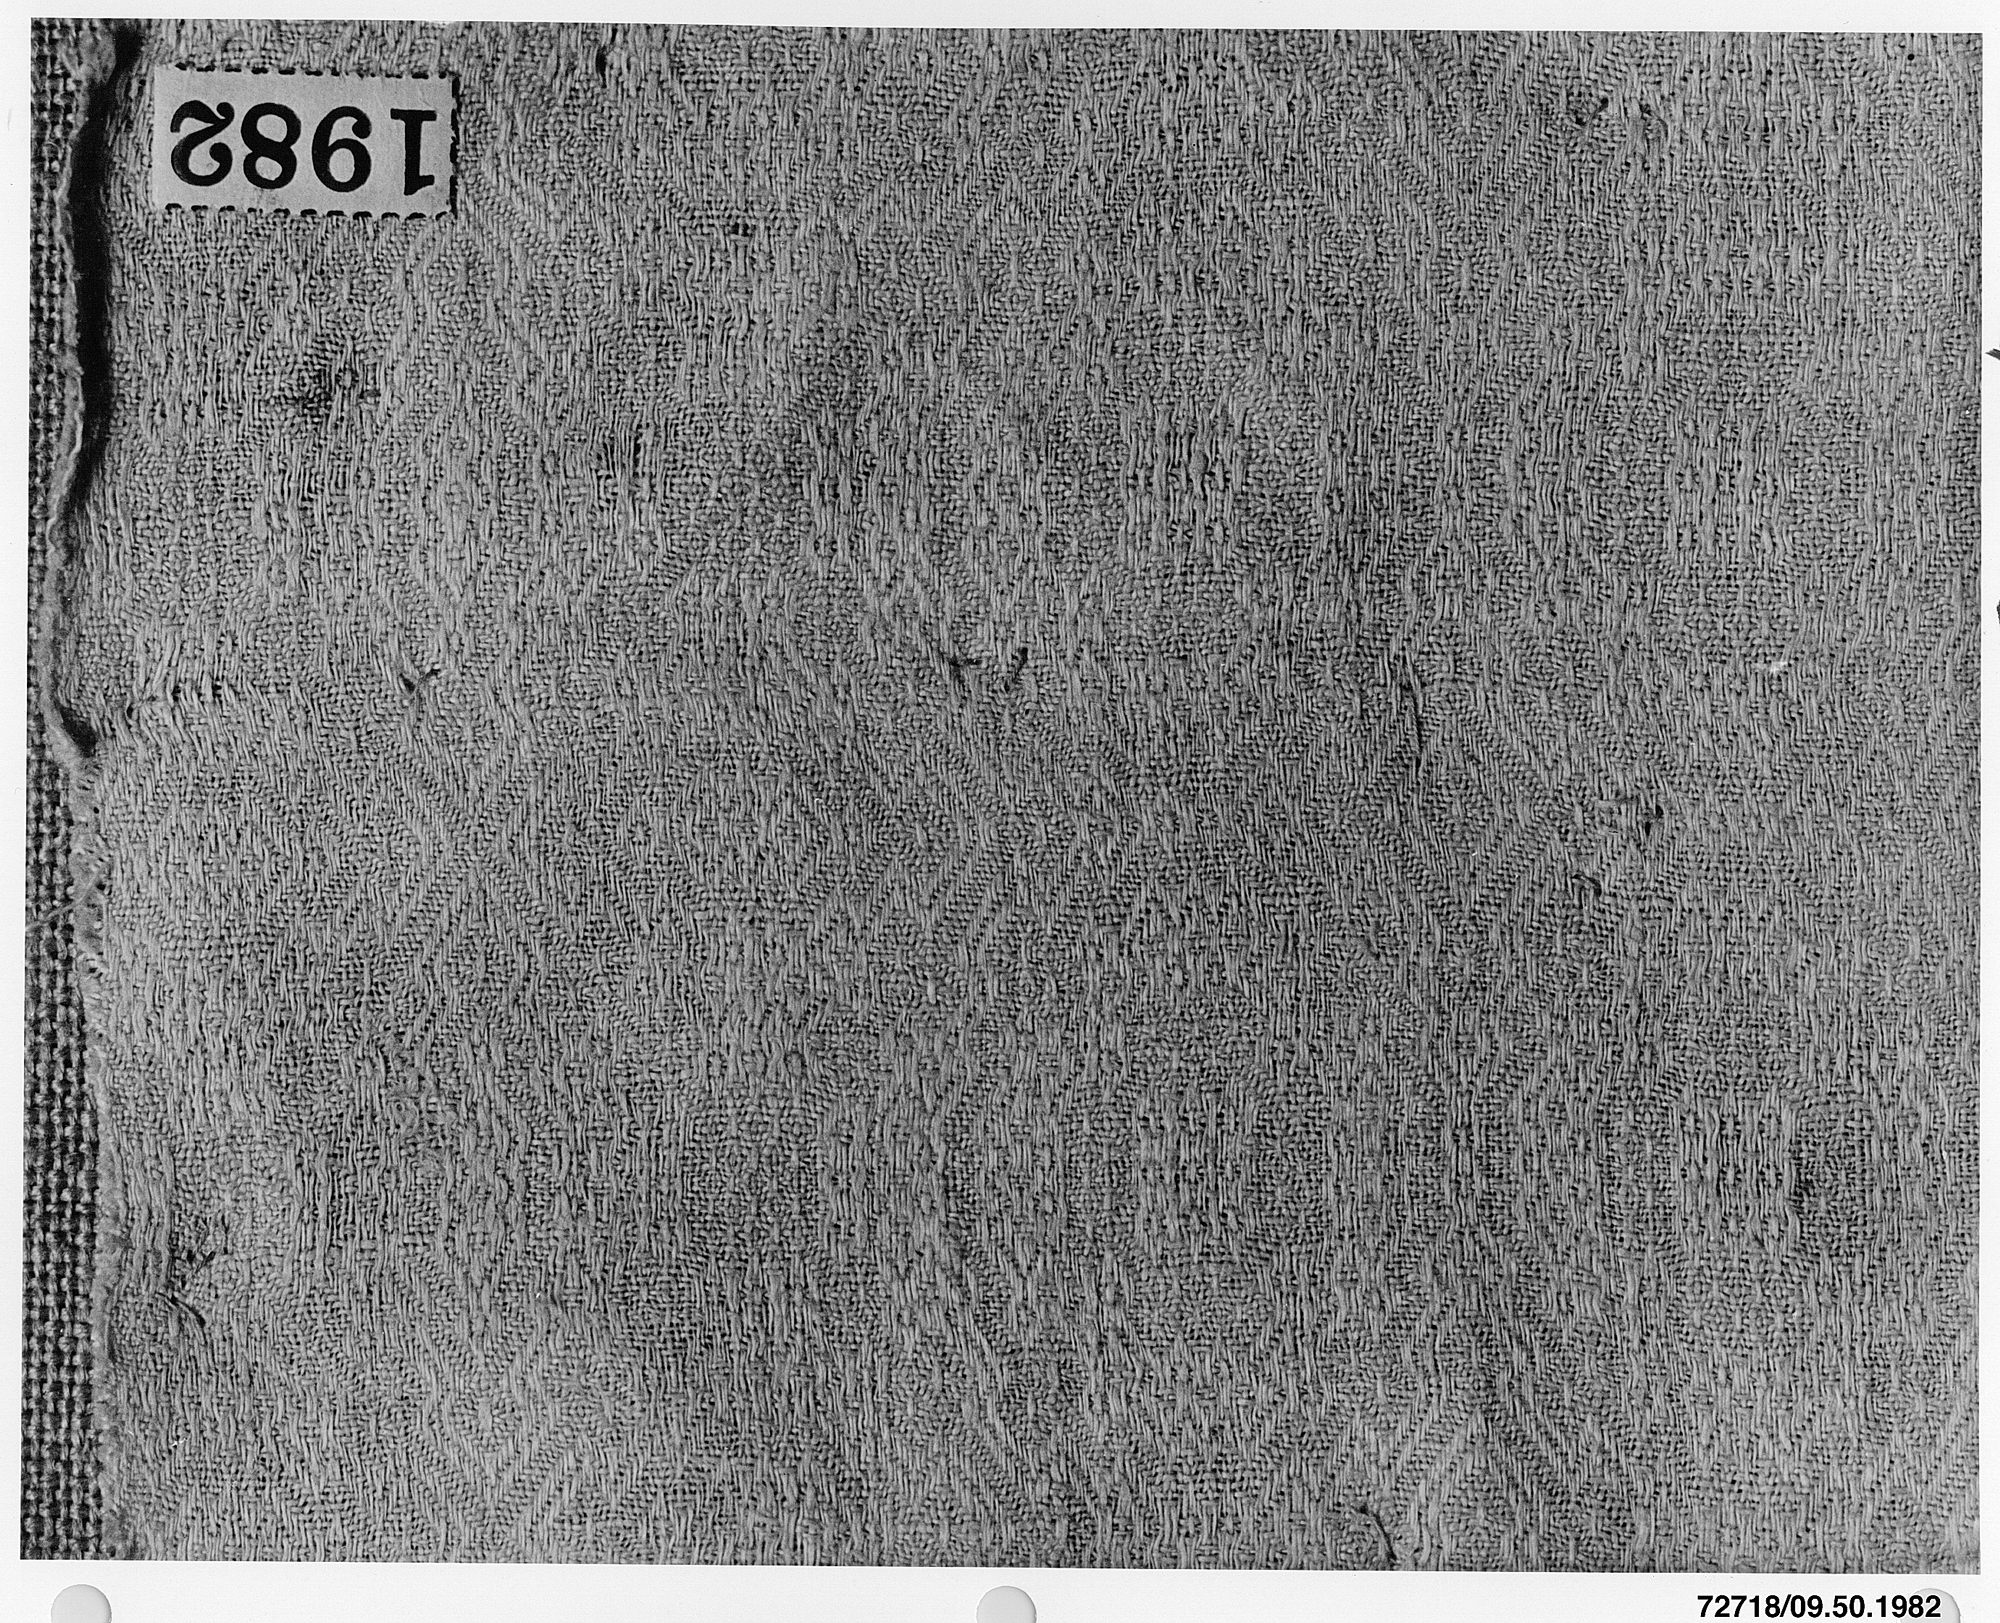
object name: piece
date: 1701-1900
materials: linen